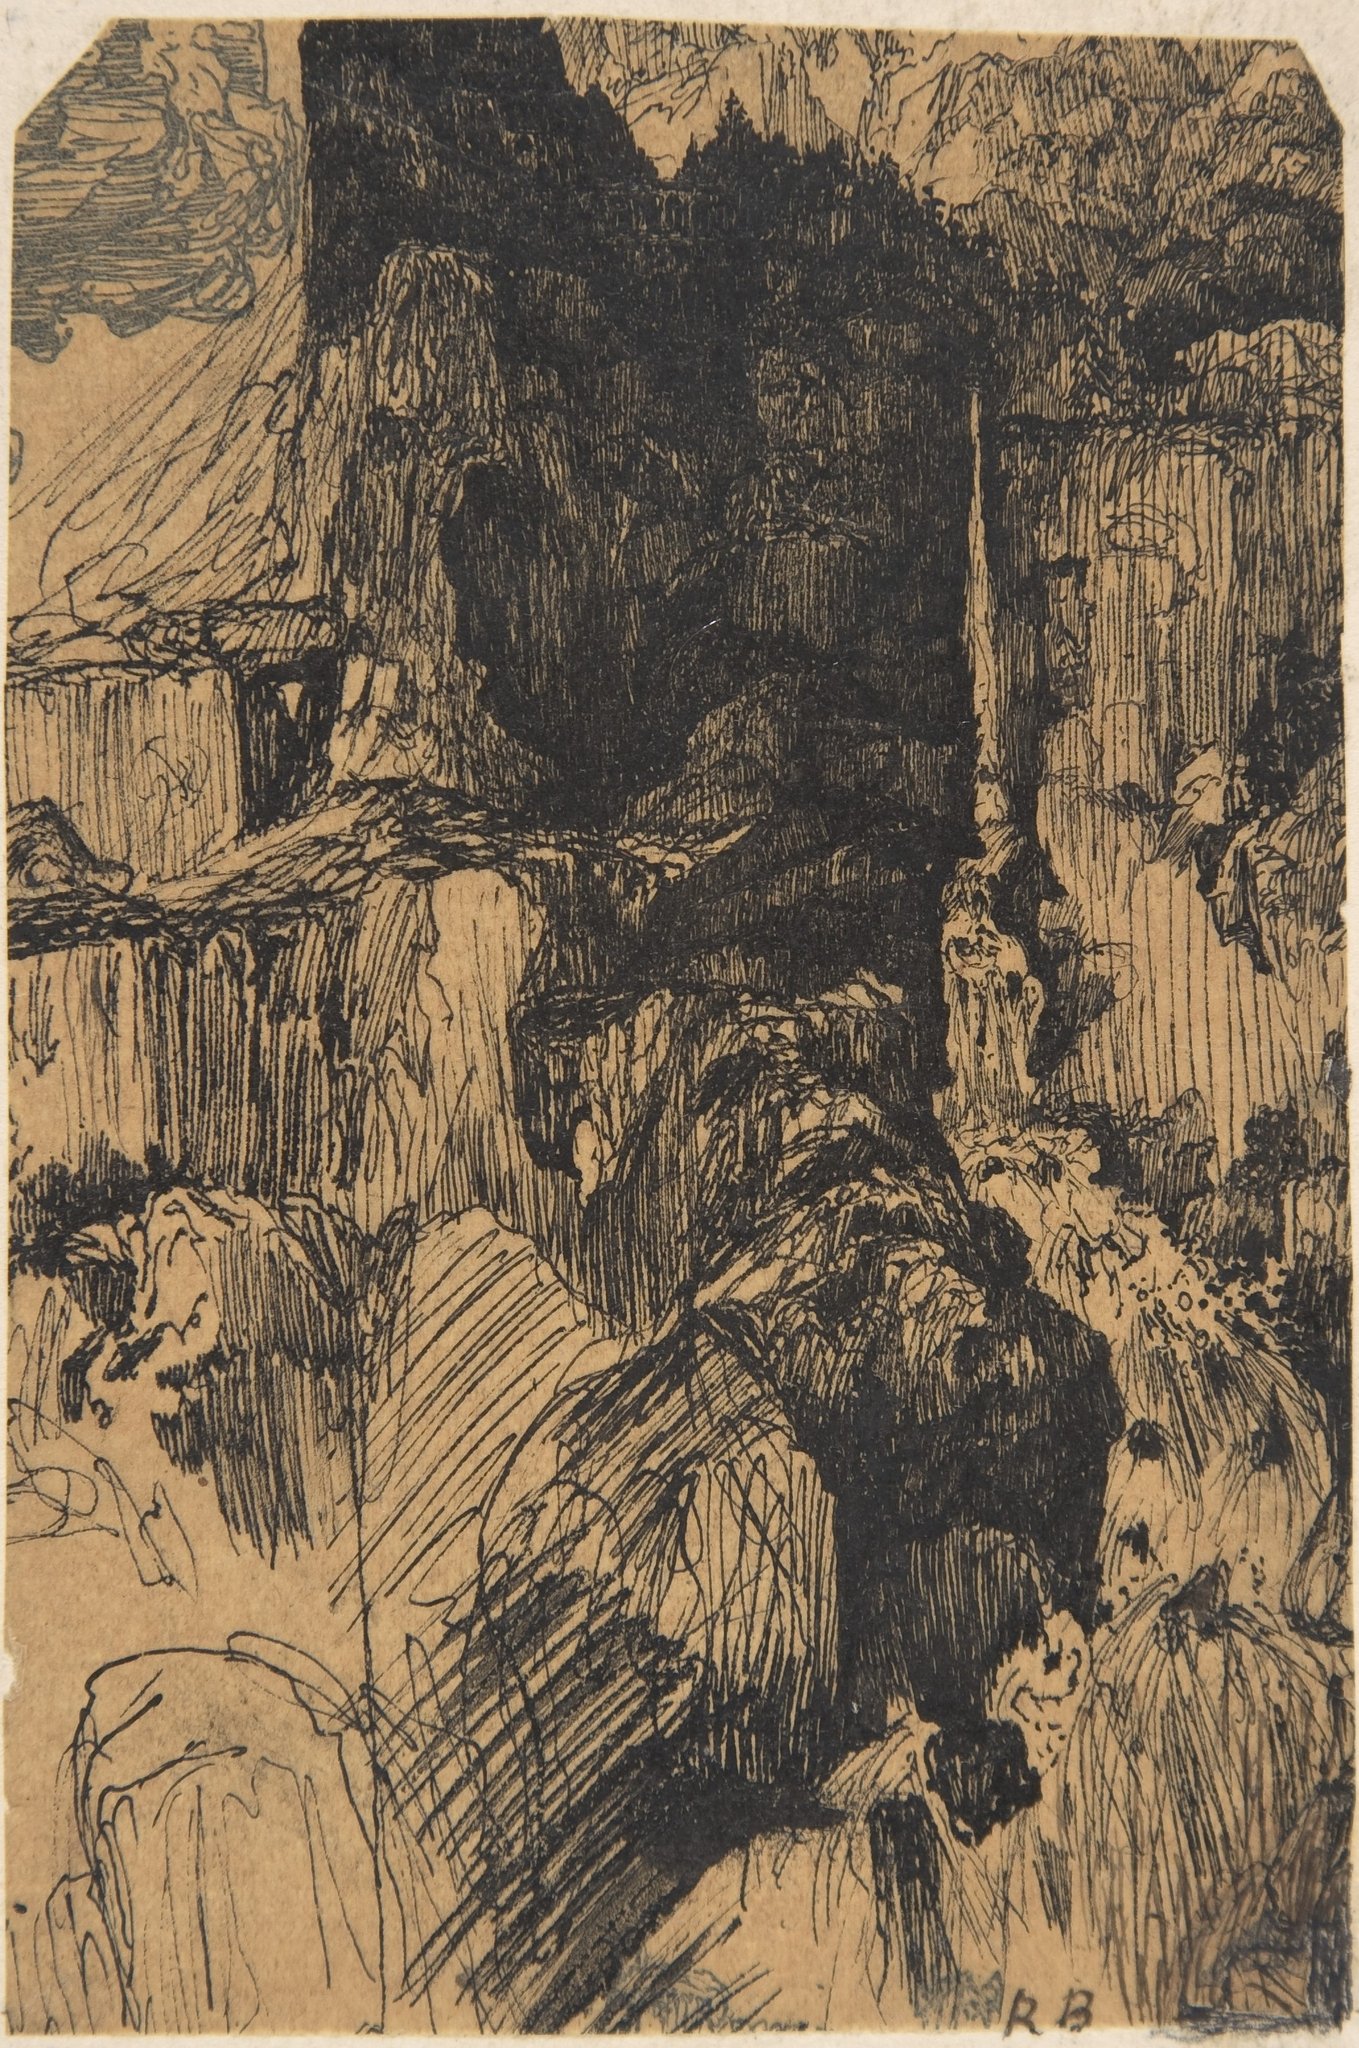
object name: drawing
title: The Crevasse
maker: rodolphe bresdin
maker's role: artist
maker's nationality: french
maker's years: 1822-1885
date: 1822-1885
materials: ink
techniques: pen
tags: abstraction